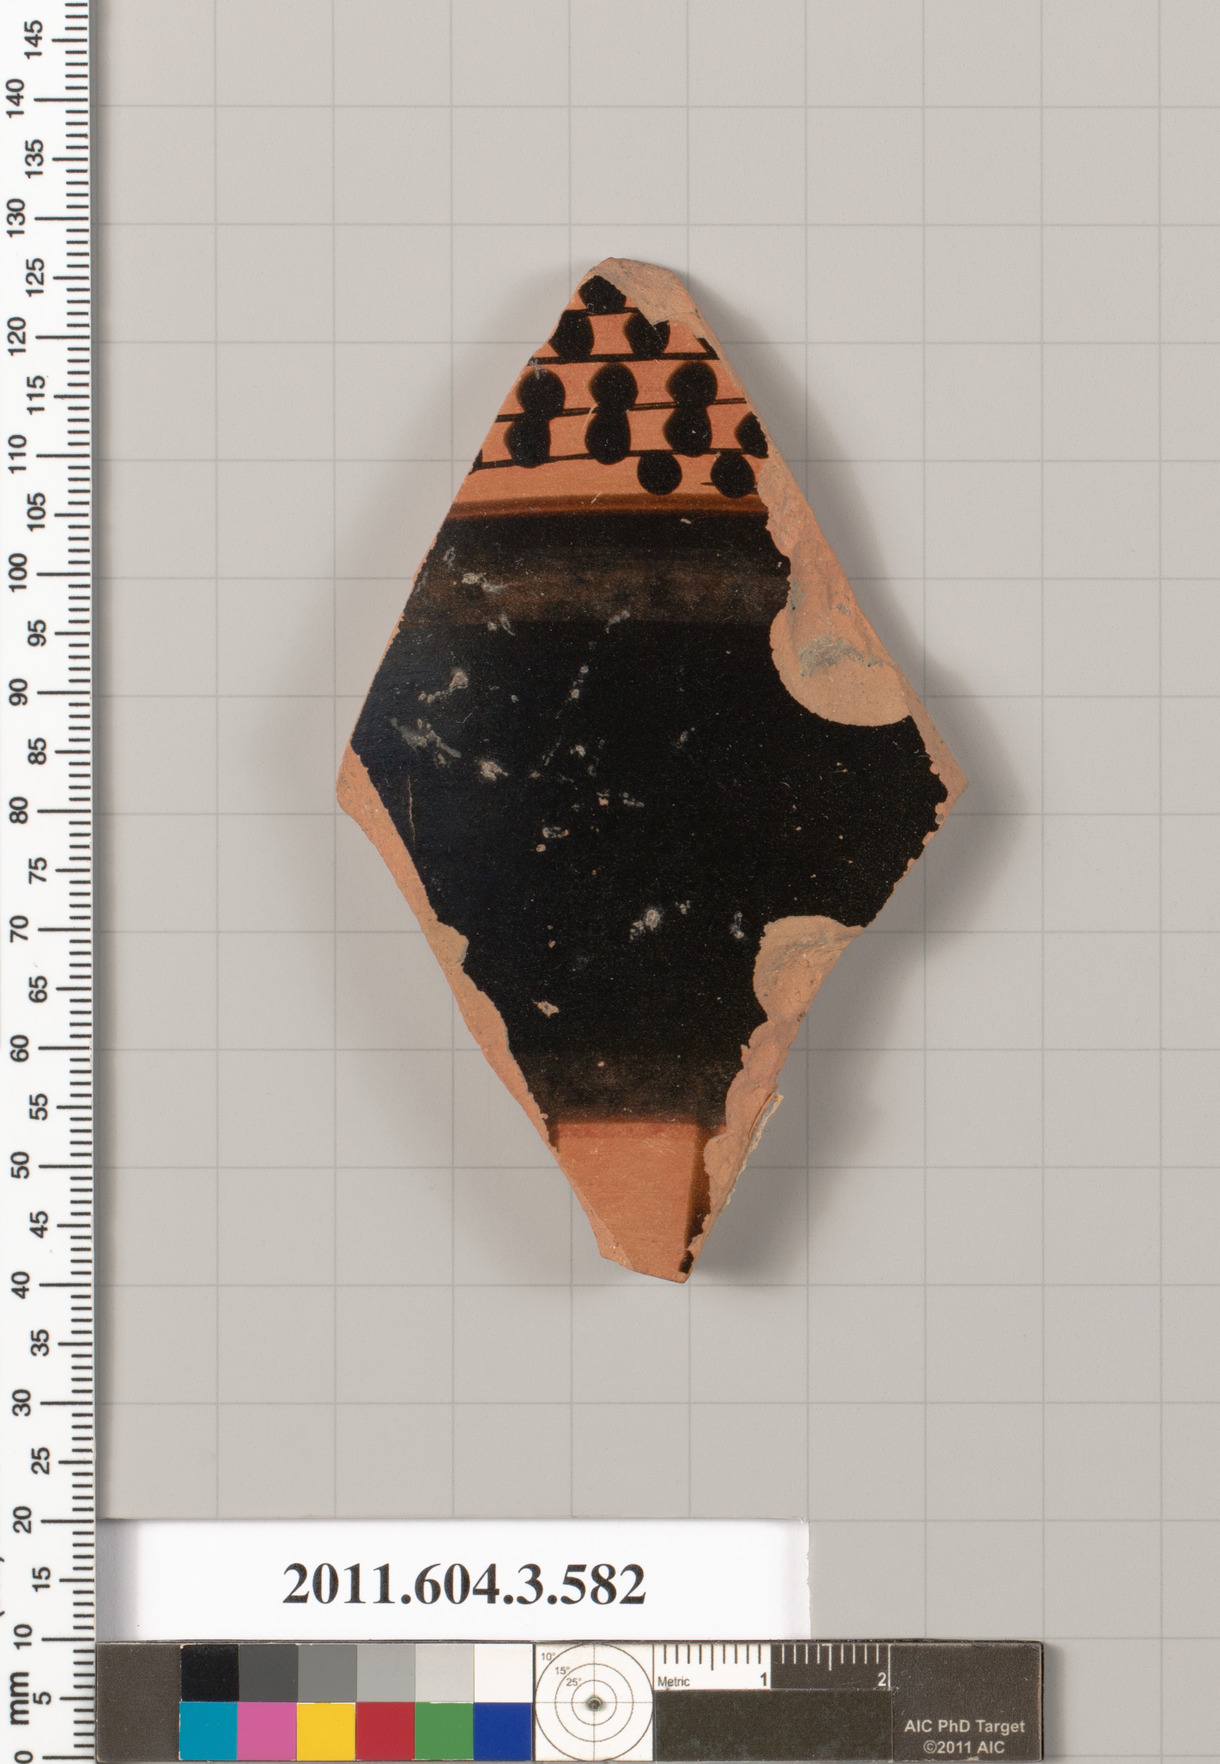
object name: column krater fragment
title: Terracotta fragment of a column-krater (bowl for mixing wine and water)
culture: greek, attic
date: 534-468 BCE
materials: terracotta